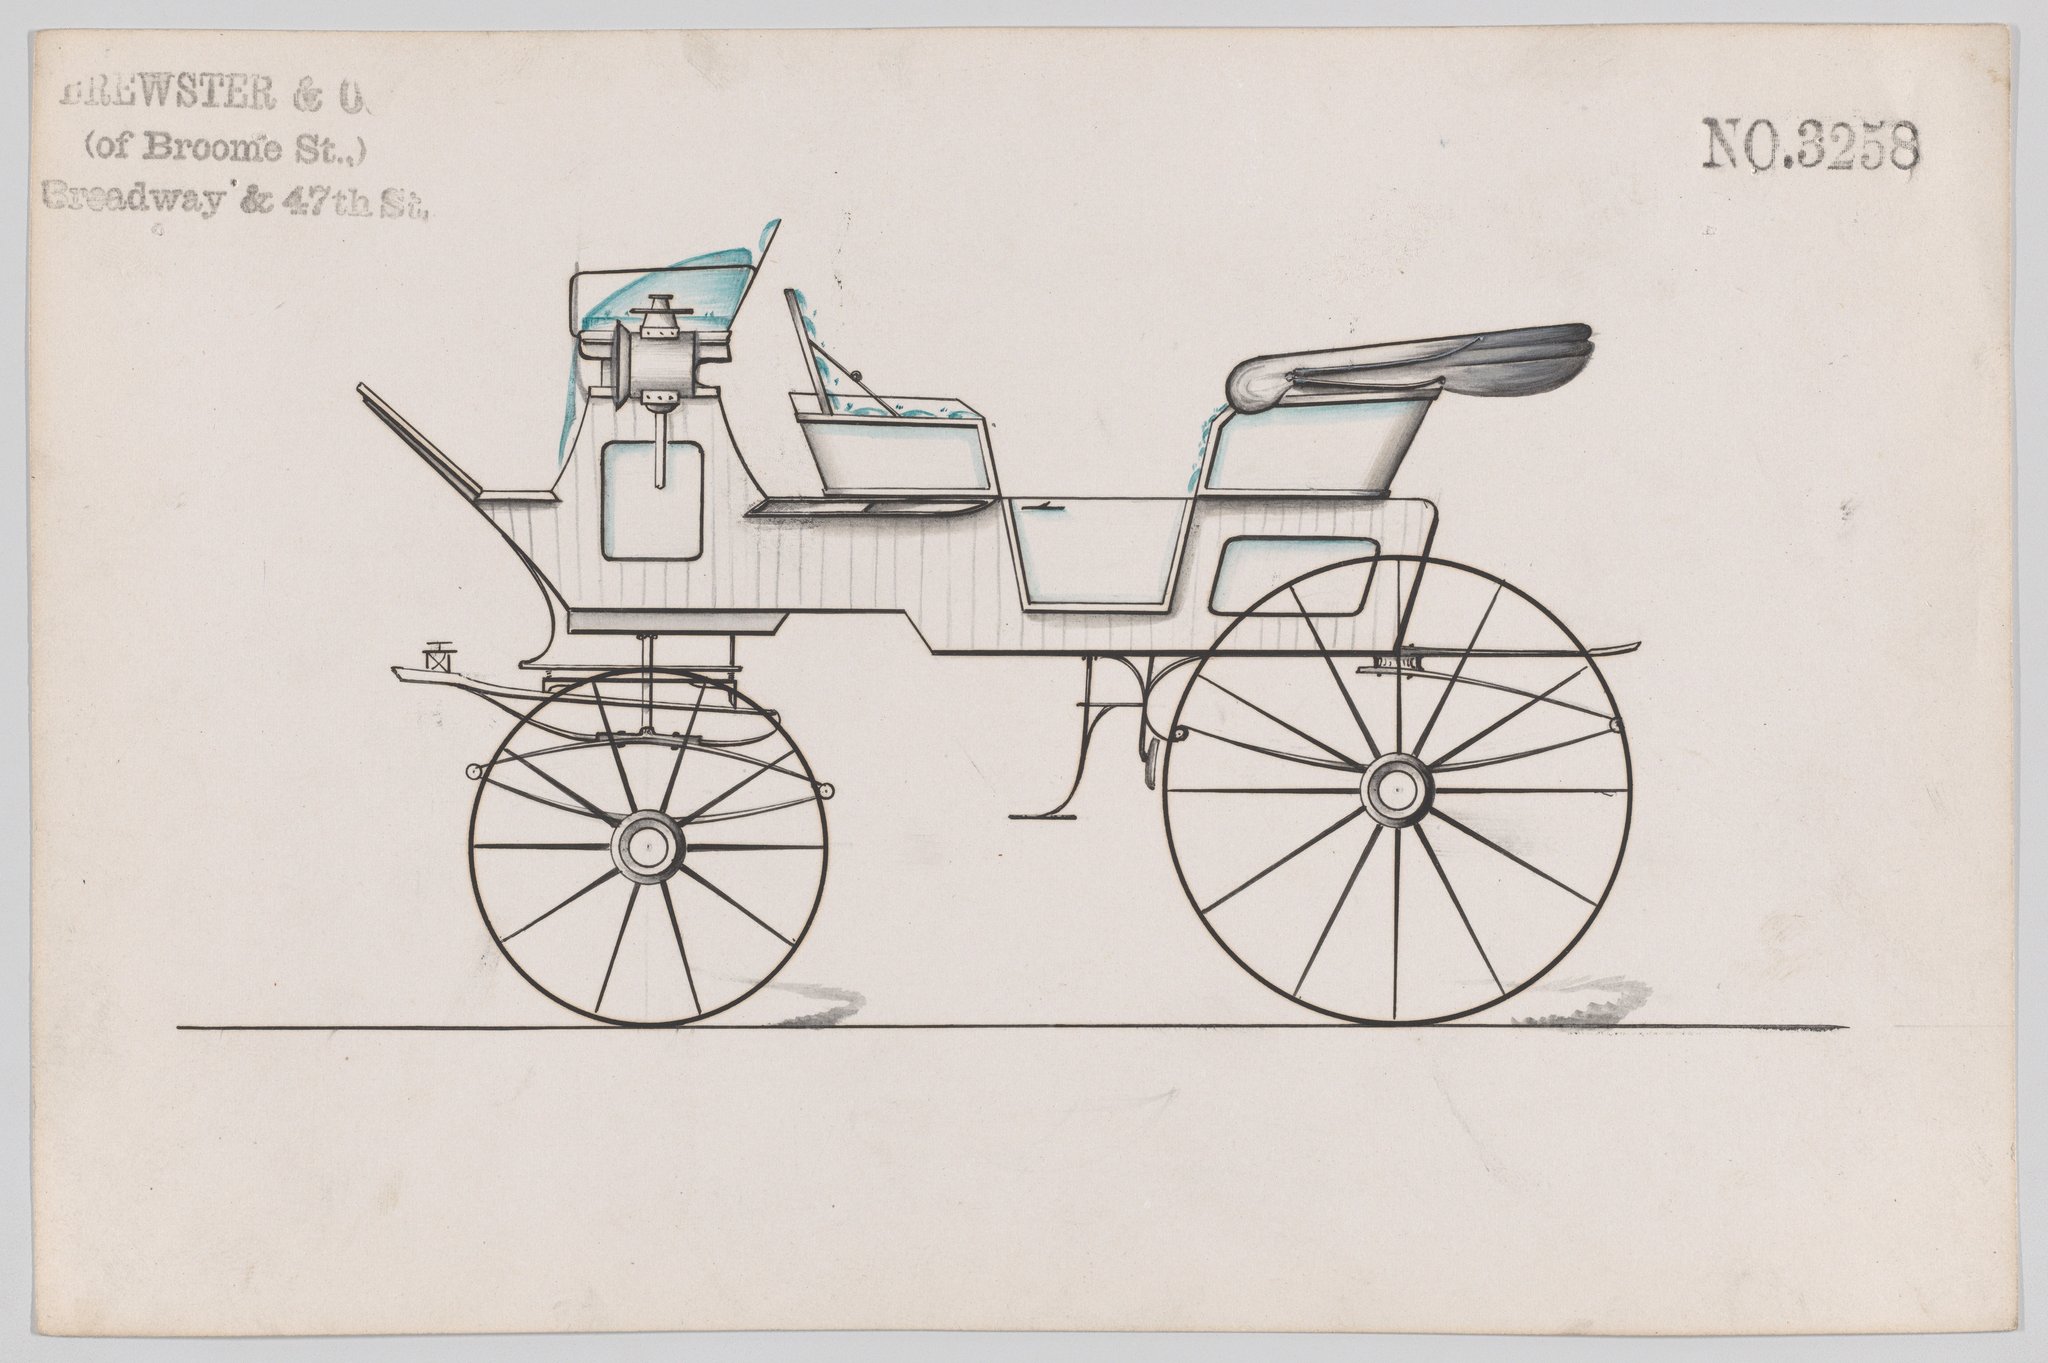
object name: drawing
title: Drag # 3258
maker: brewster & co.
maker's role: manufacturer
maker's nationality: american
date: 1876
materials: ink, watercolor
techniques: pen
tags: carriages